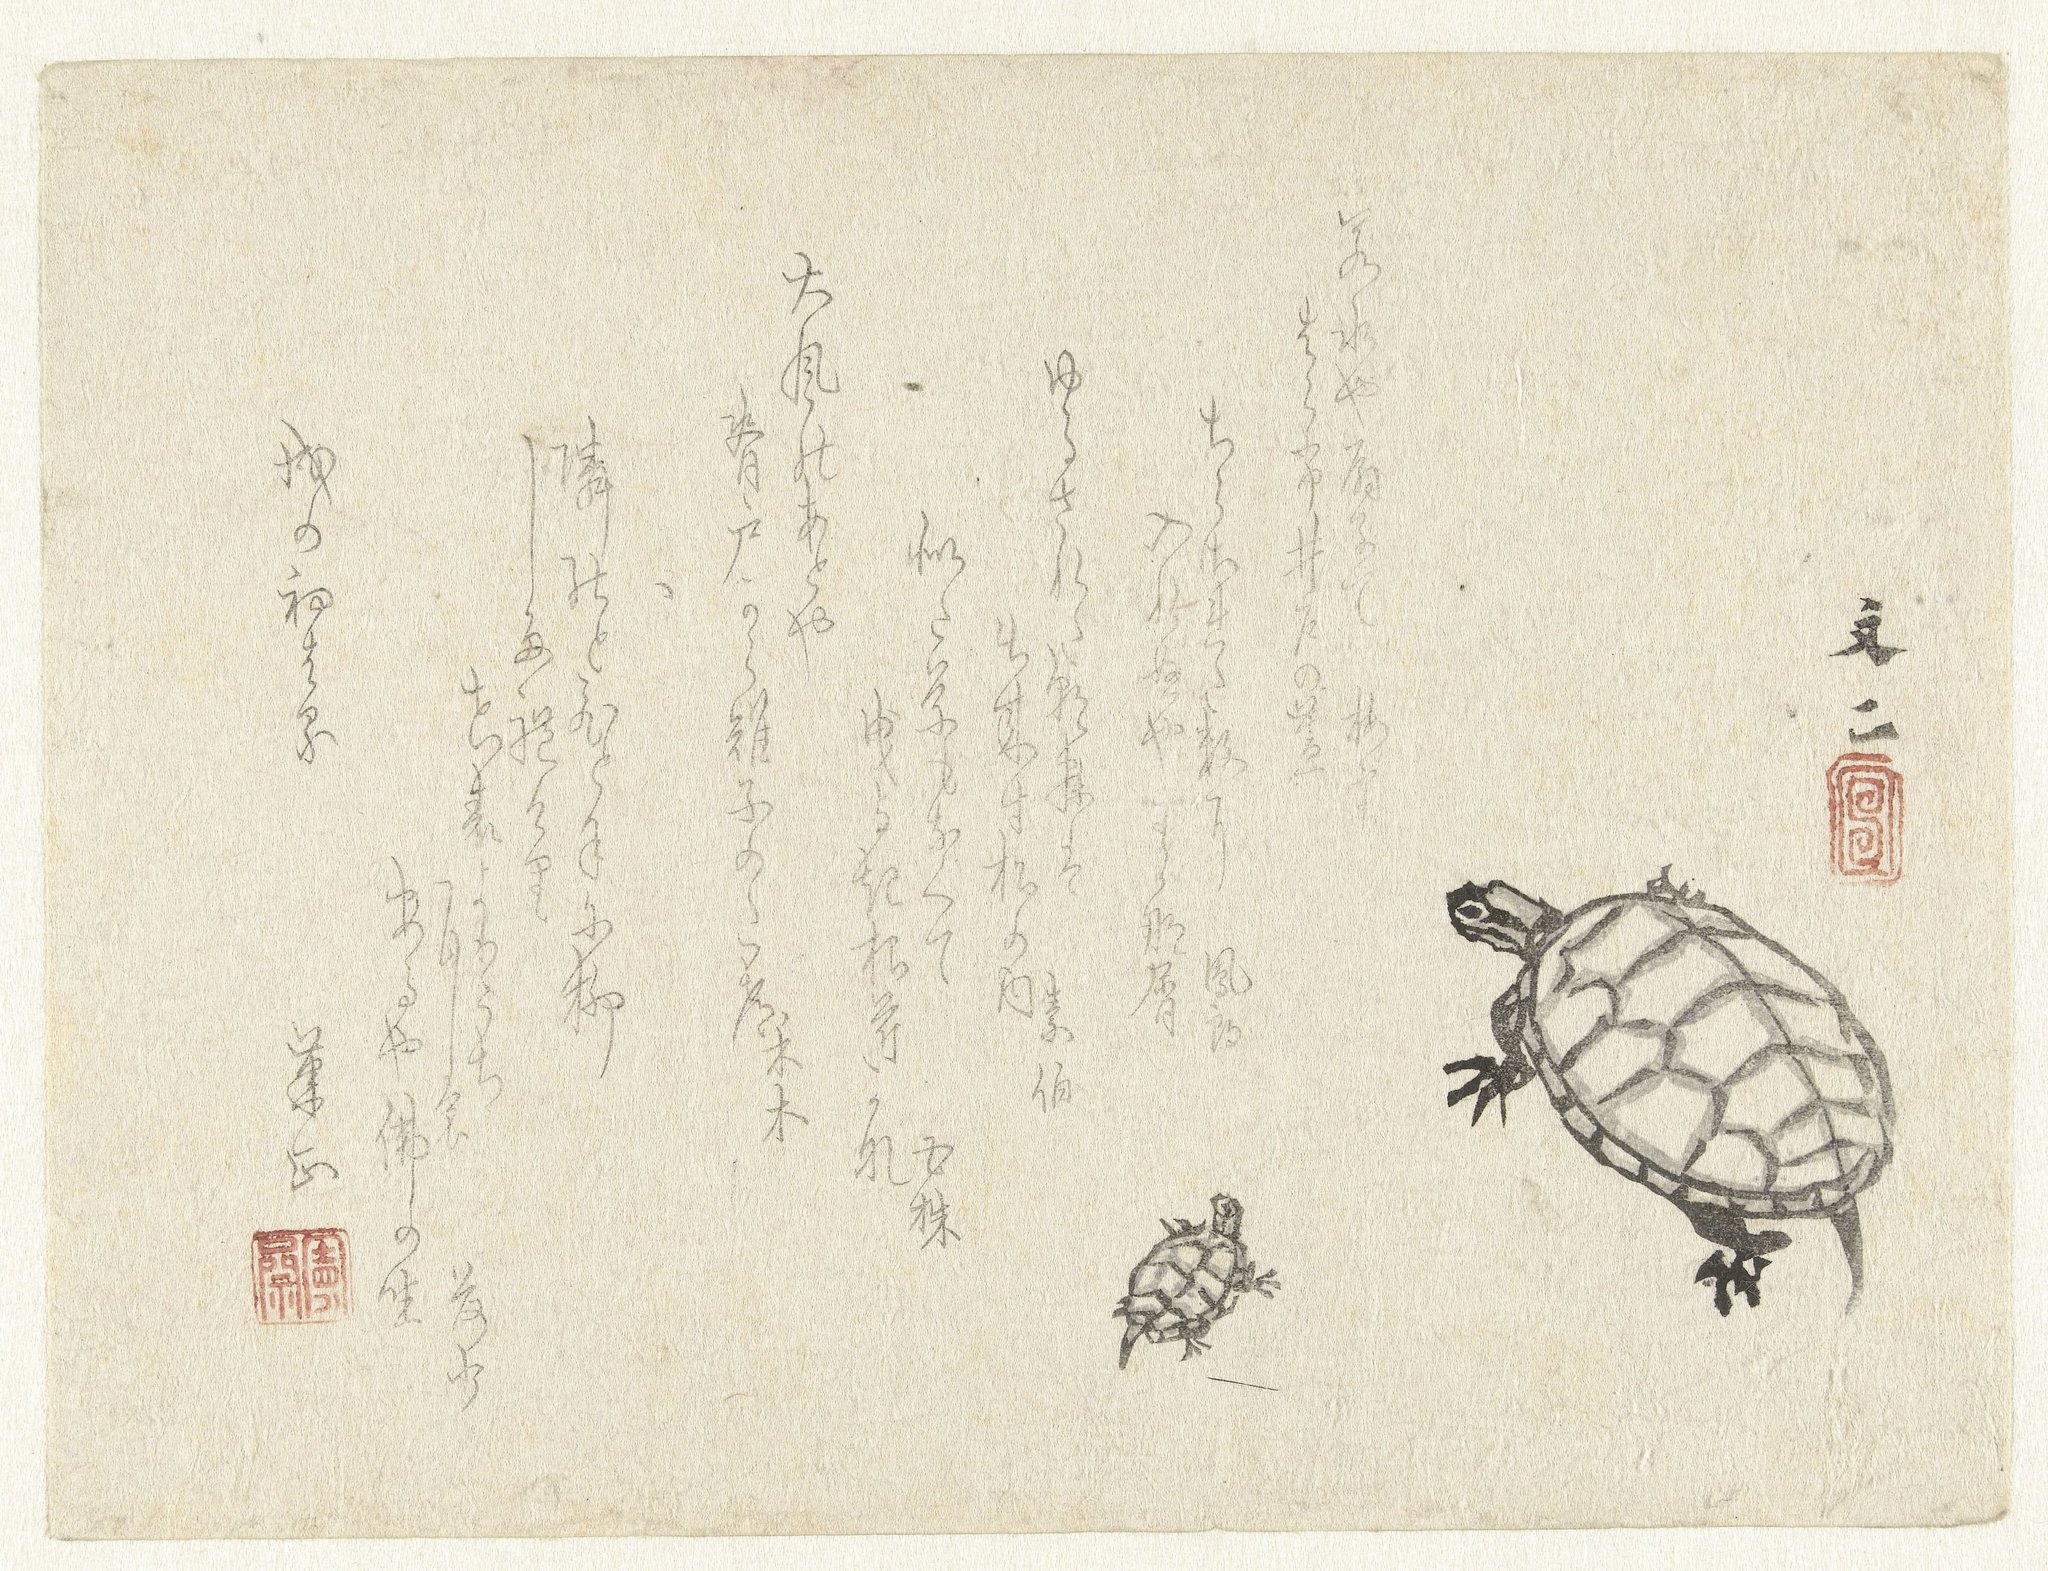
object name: print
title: Twee schildpadden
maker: tani bunji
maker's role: print maker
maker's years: -1850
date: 1815-1839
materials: paper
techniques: woodcut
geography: japan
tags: tortoises, turtles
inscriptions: collector's mark: Lugt 2228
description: Een surimono is een luxe uitgevoerde prent waarop beeld met één of meerdere gedichten gecombineerd is. Bij het drukken van een surimono werd vaak gebruik gemaakt van dikker papier, blinddruk en metaal pigmenten, zoals koper- en zilverpoeder. De prenten werden vaak in opdracht van dichters gemaakt en als exclusief geschenk aan vrienden en relaties gegeven.